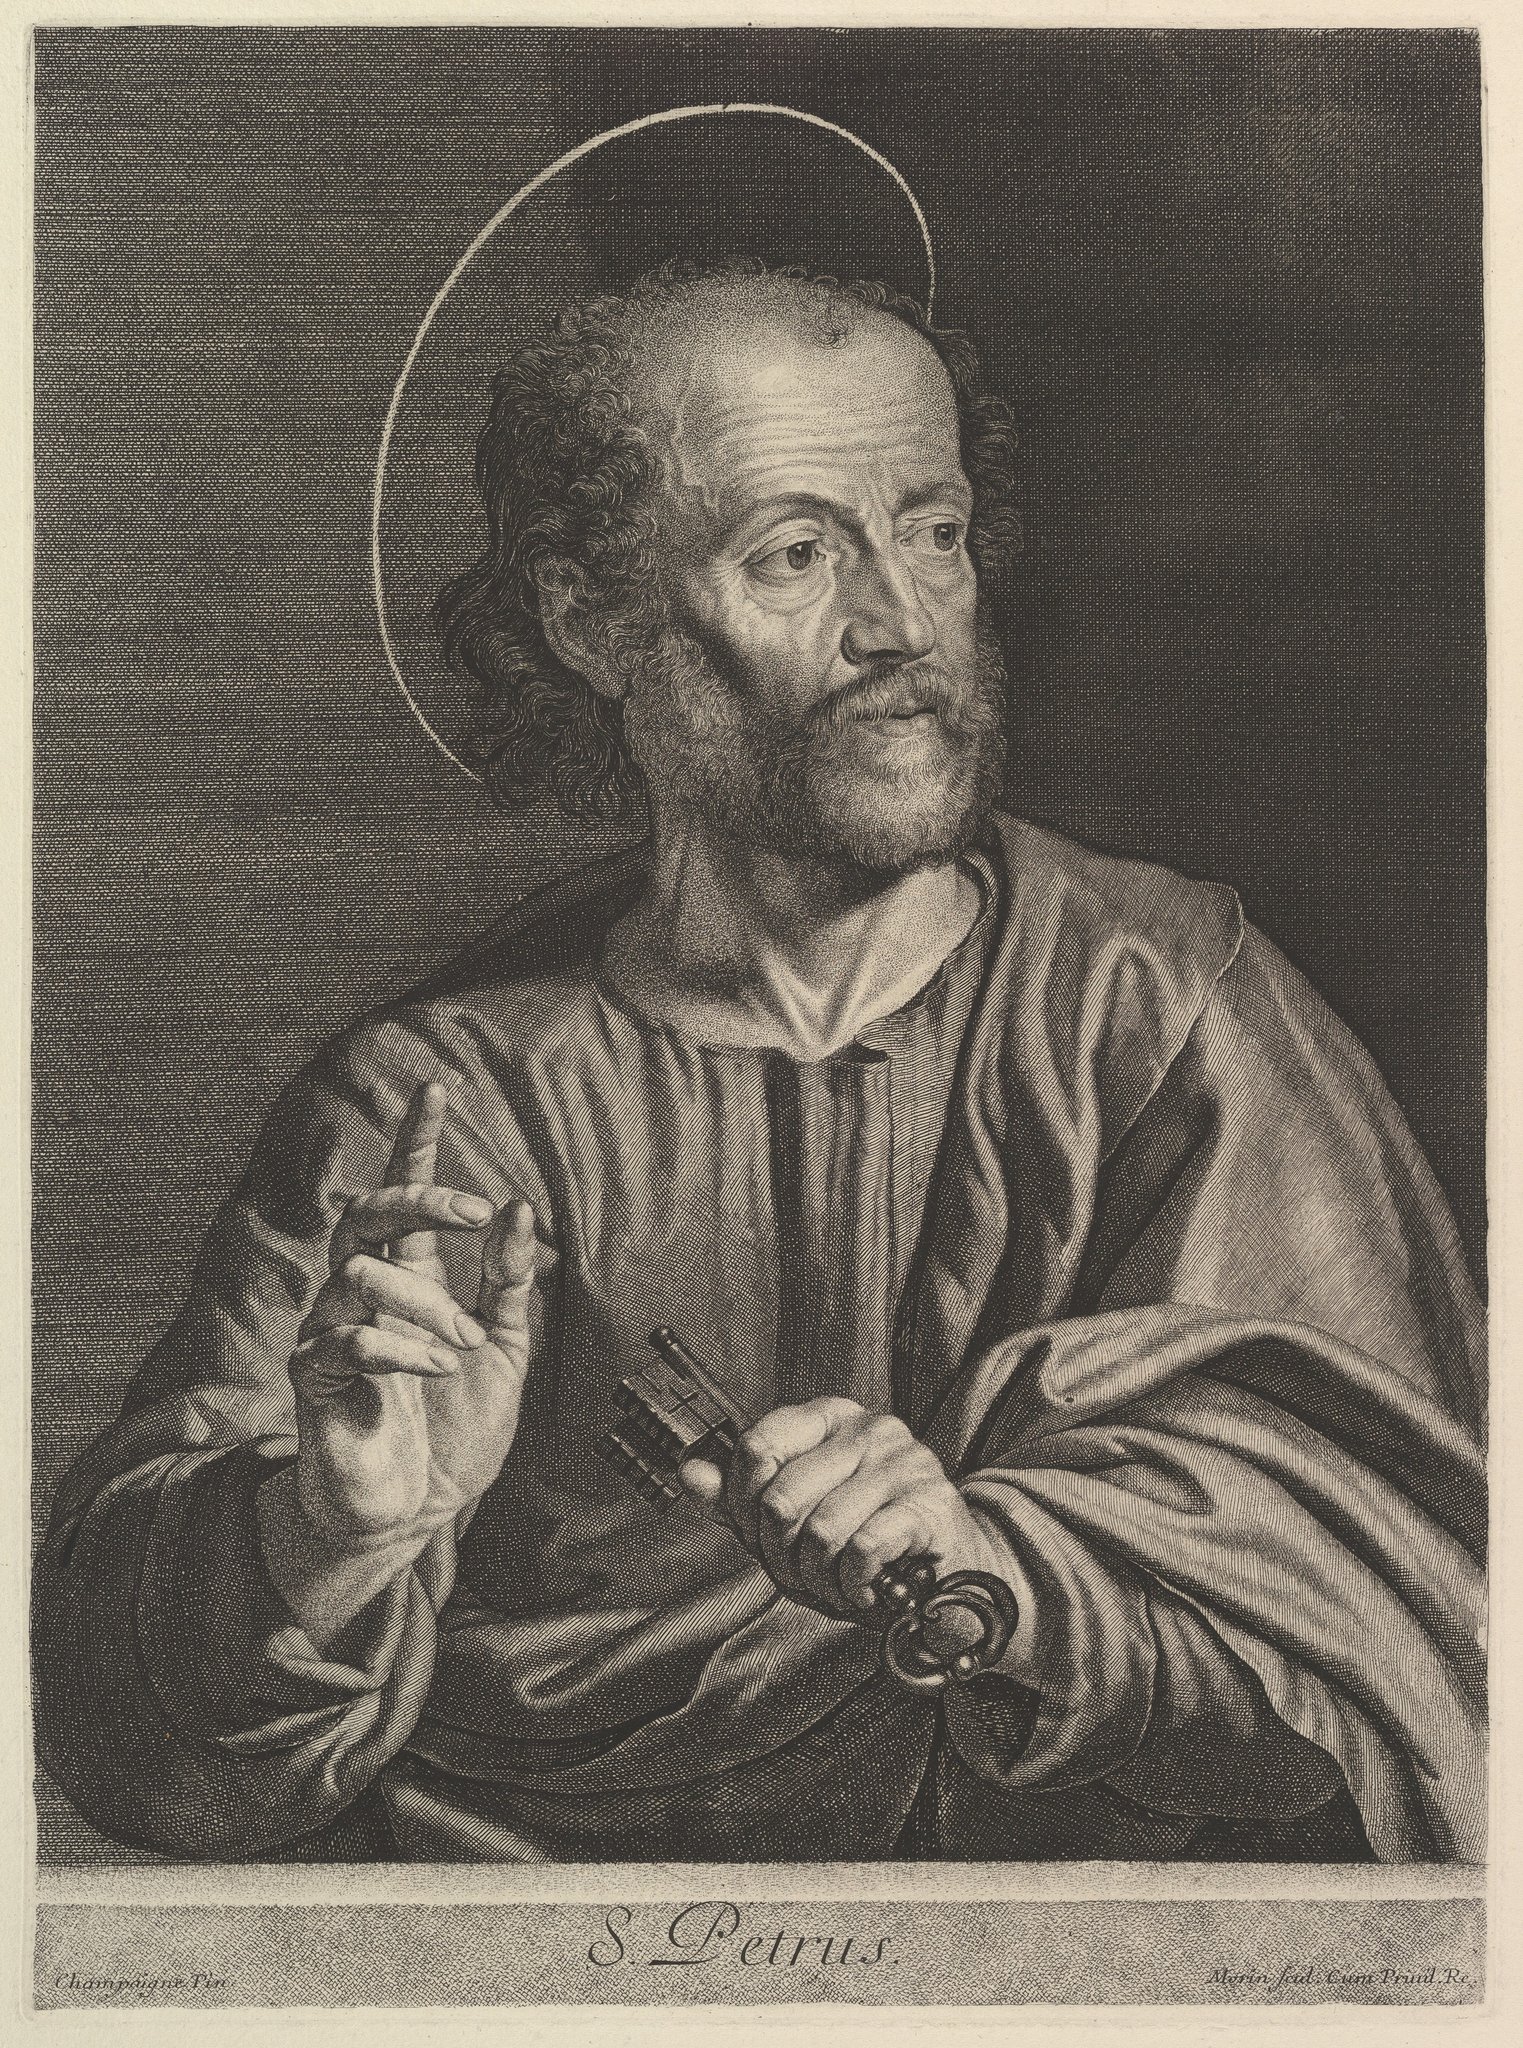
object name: print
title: Saint Pierre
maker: jean morin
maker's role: artist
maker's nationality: french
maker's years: 1605-1650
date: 1605-1650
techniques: etching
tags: men,portraits,saints